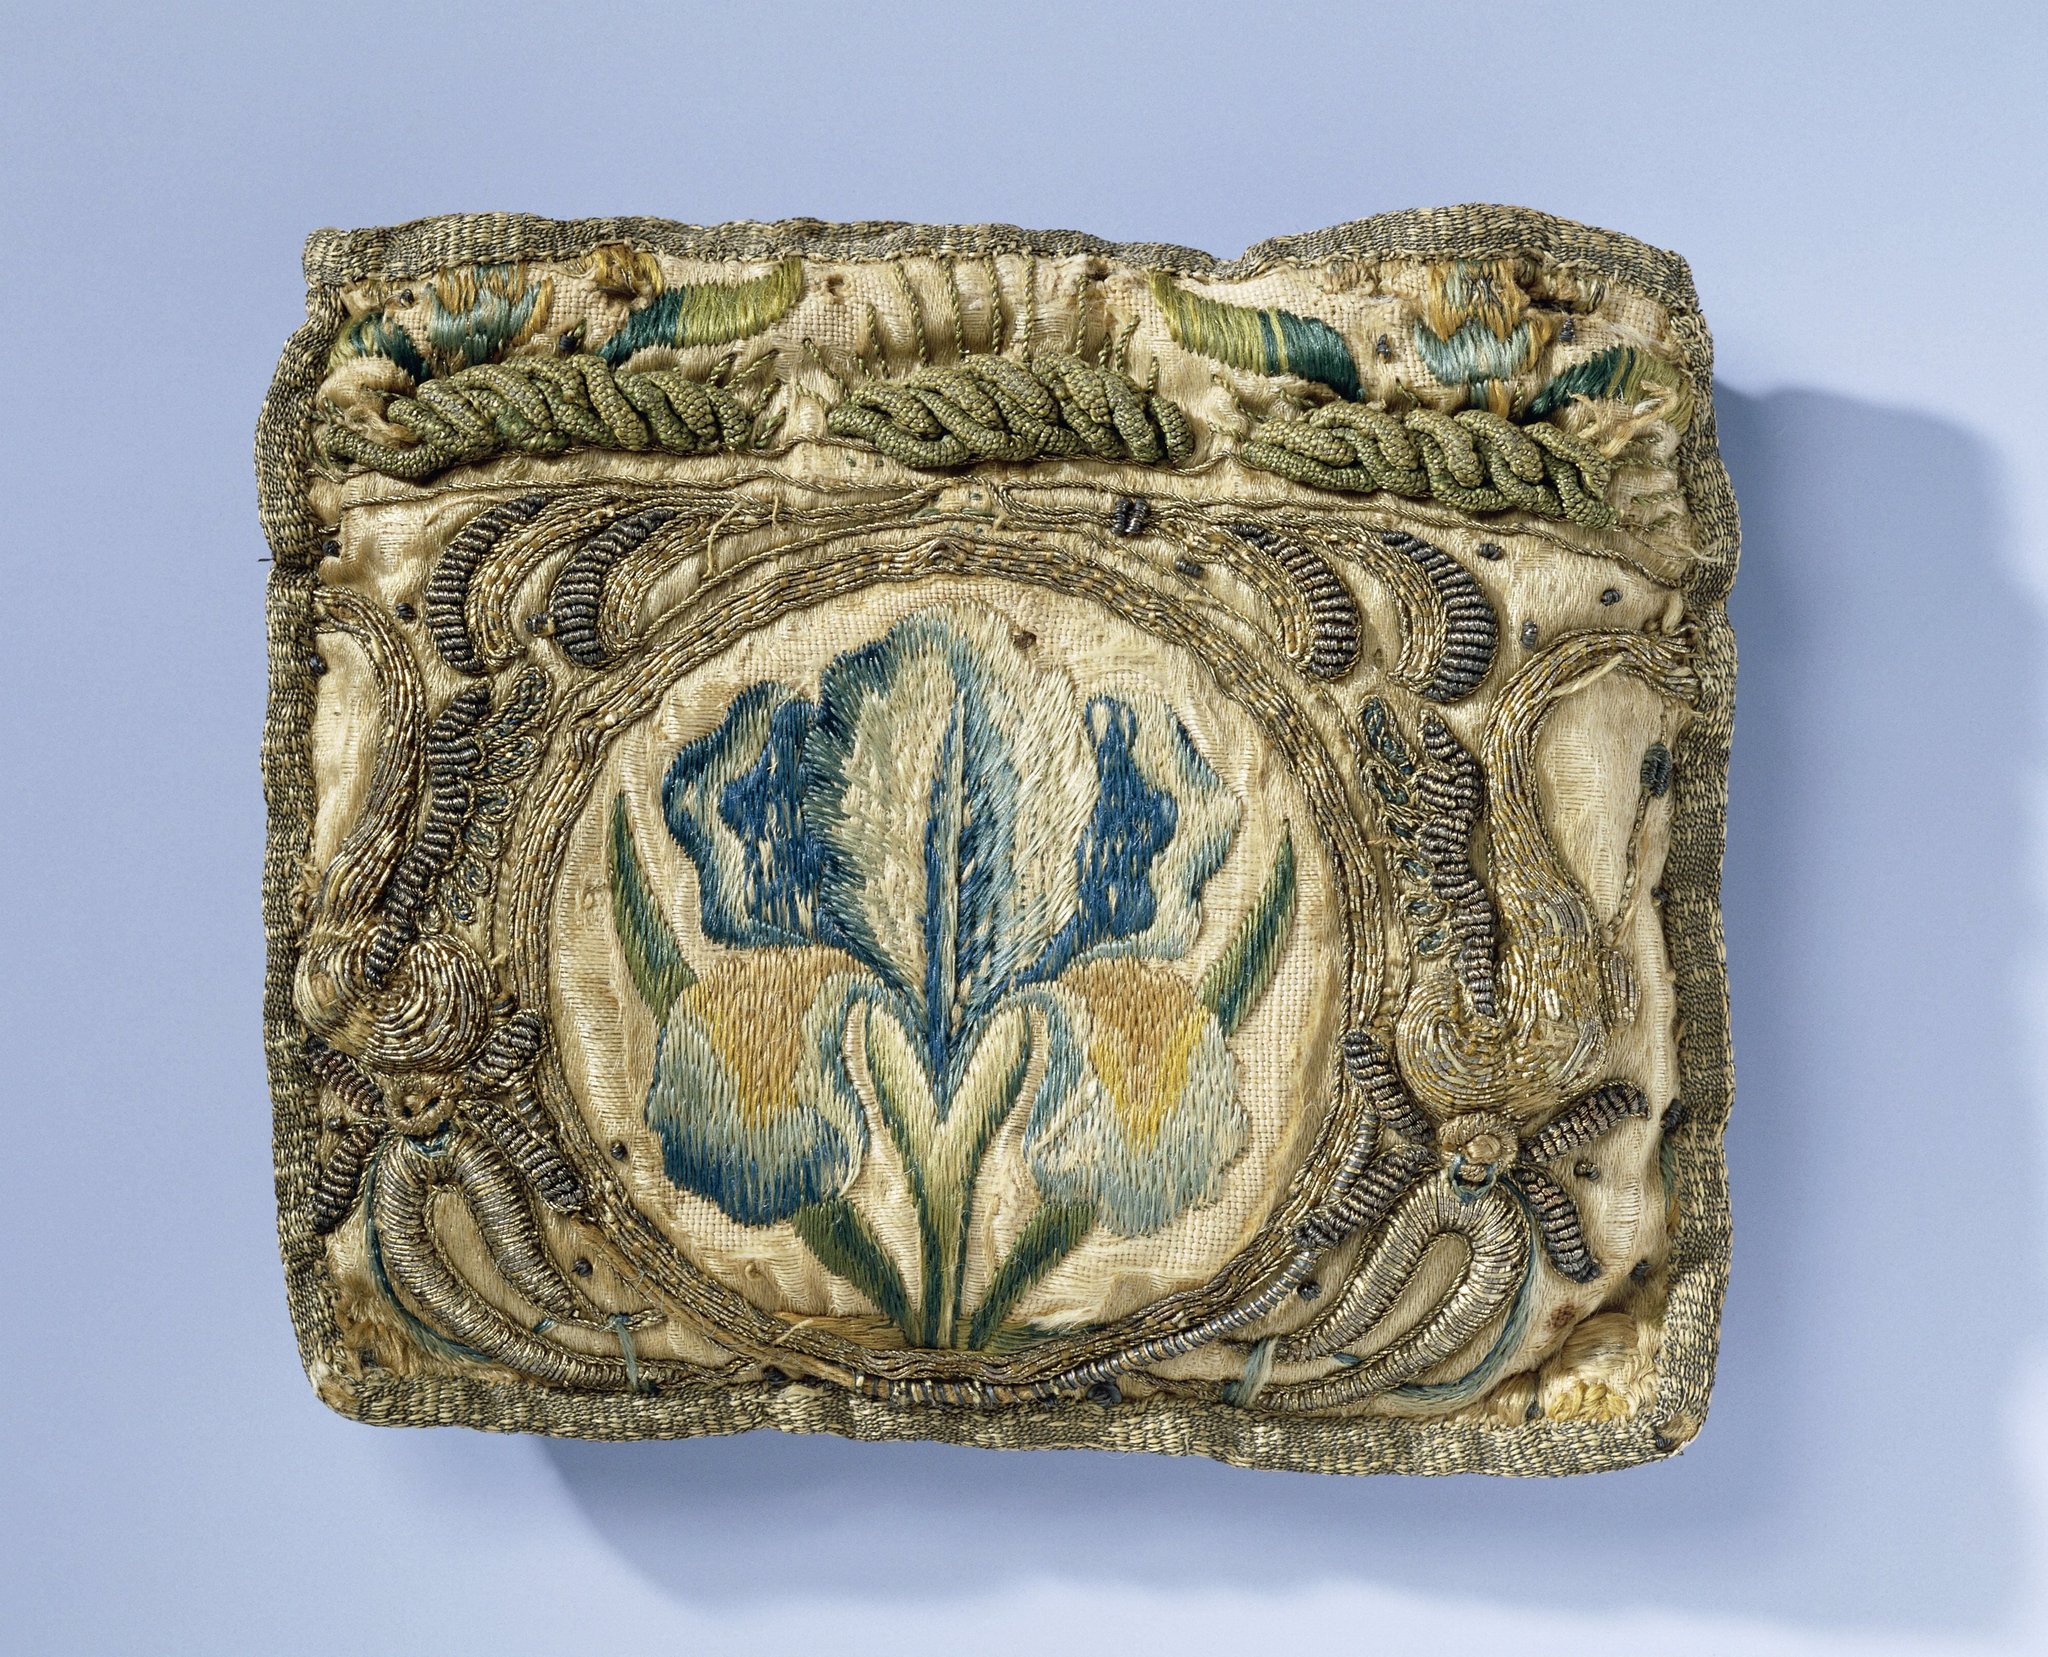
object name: beurs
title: Beurs van gele zijde, geborduurd met iris in veelkleurige vloszijde en ornamenten in gouddraad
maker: Anonymous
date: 1675-1700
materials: gold thread, silk, thread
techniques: embroidered, weave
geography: netherlands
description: Beurs, zijde, floszijde, goud- en zilverdraad, zilver cantille, linnen, zijde Nederland(?), ca. 1675-1700 Inv. BK-NM-1113